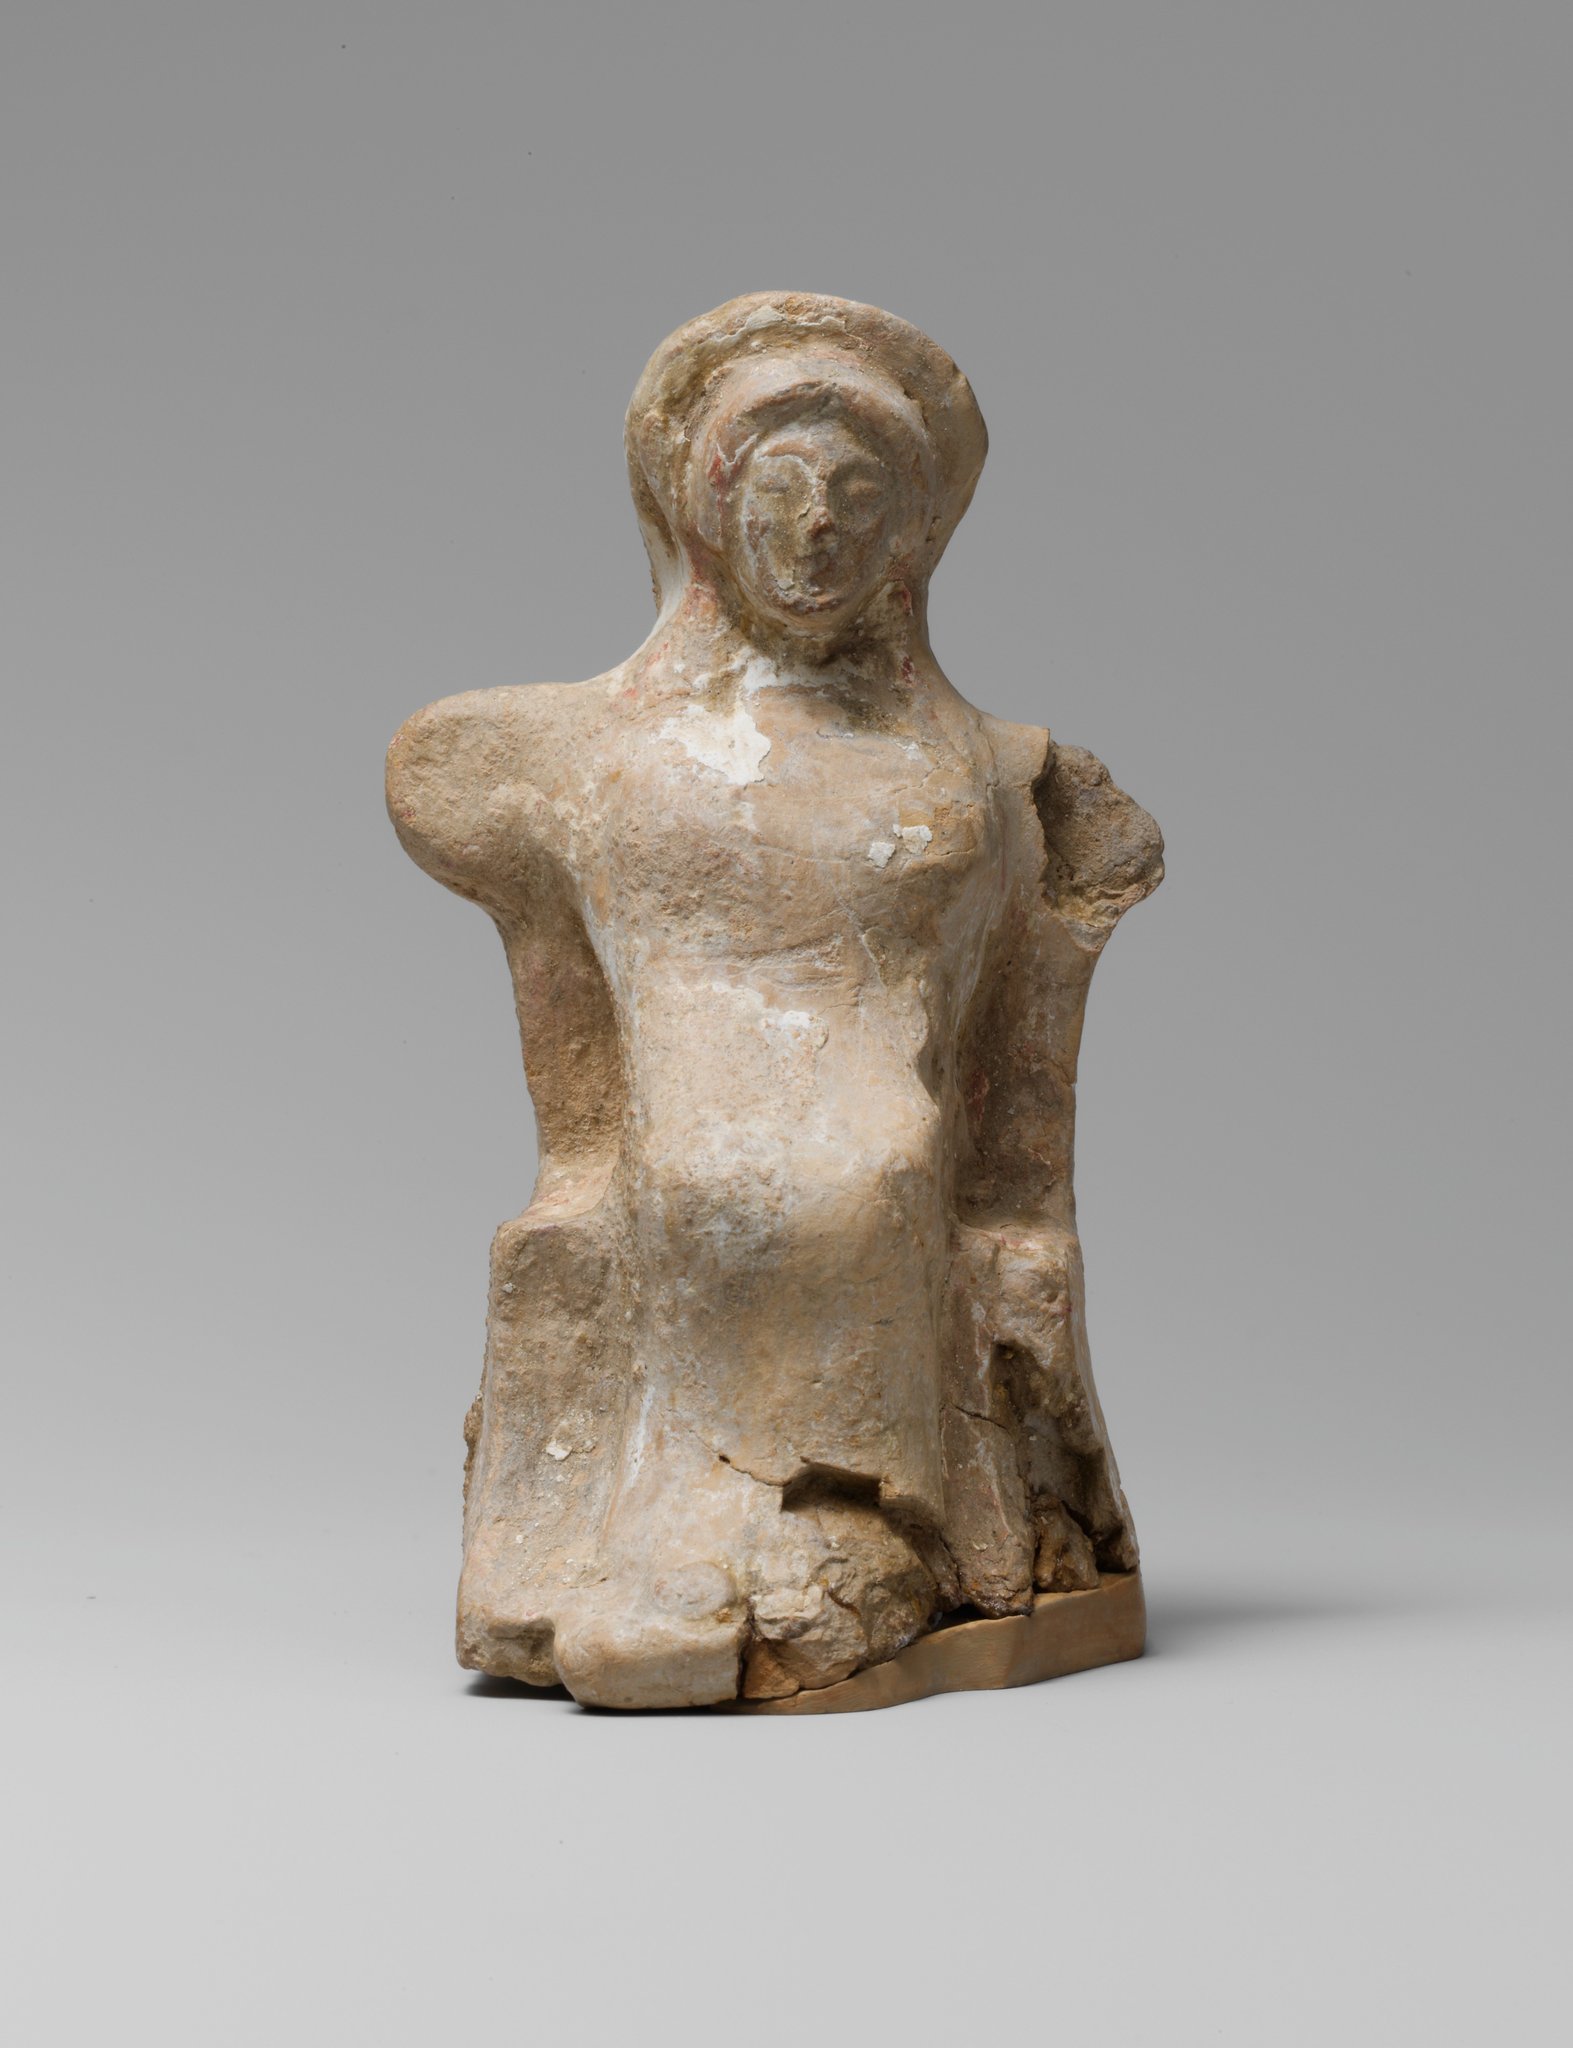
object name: statuette of a woman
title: Terracotta statuette of a seated woman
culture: greek, attic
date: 525-500 BCE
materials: terracotta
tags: women